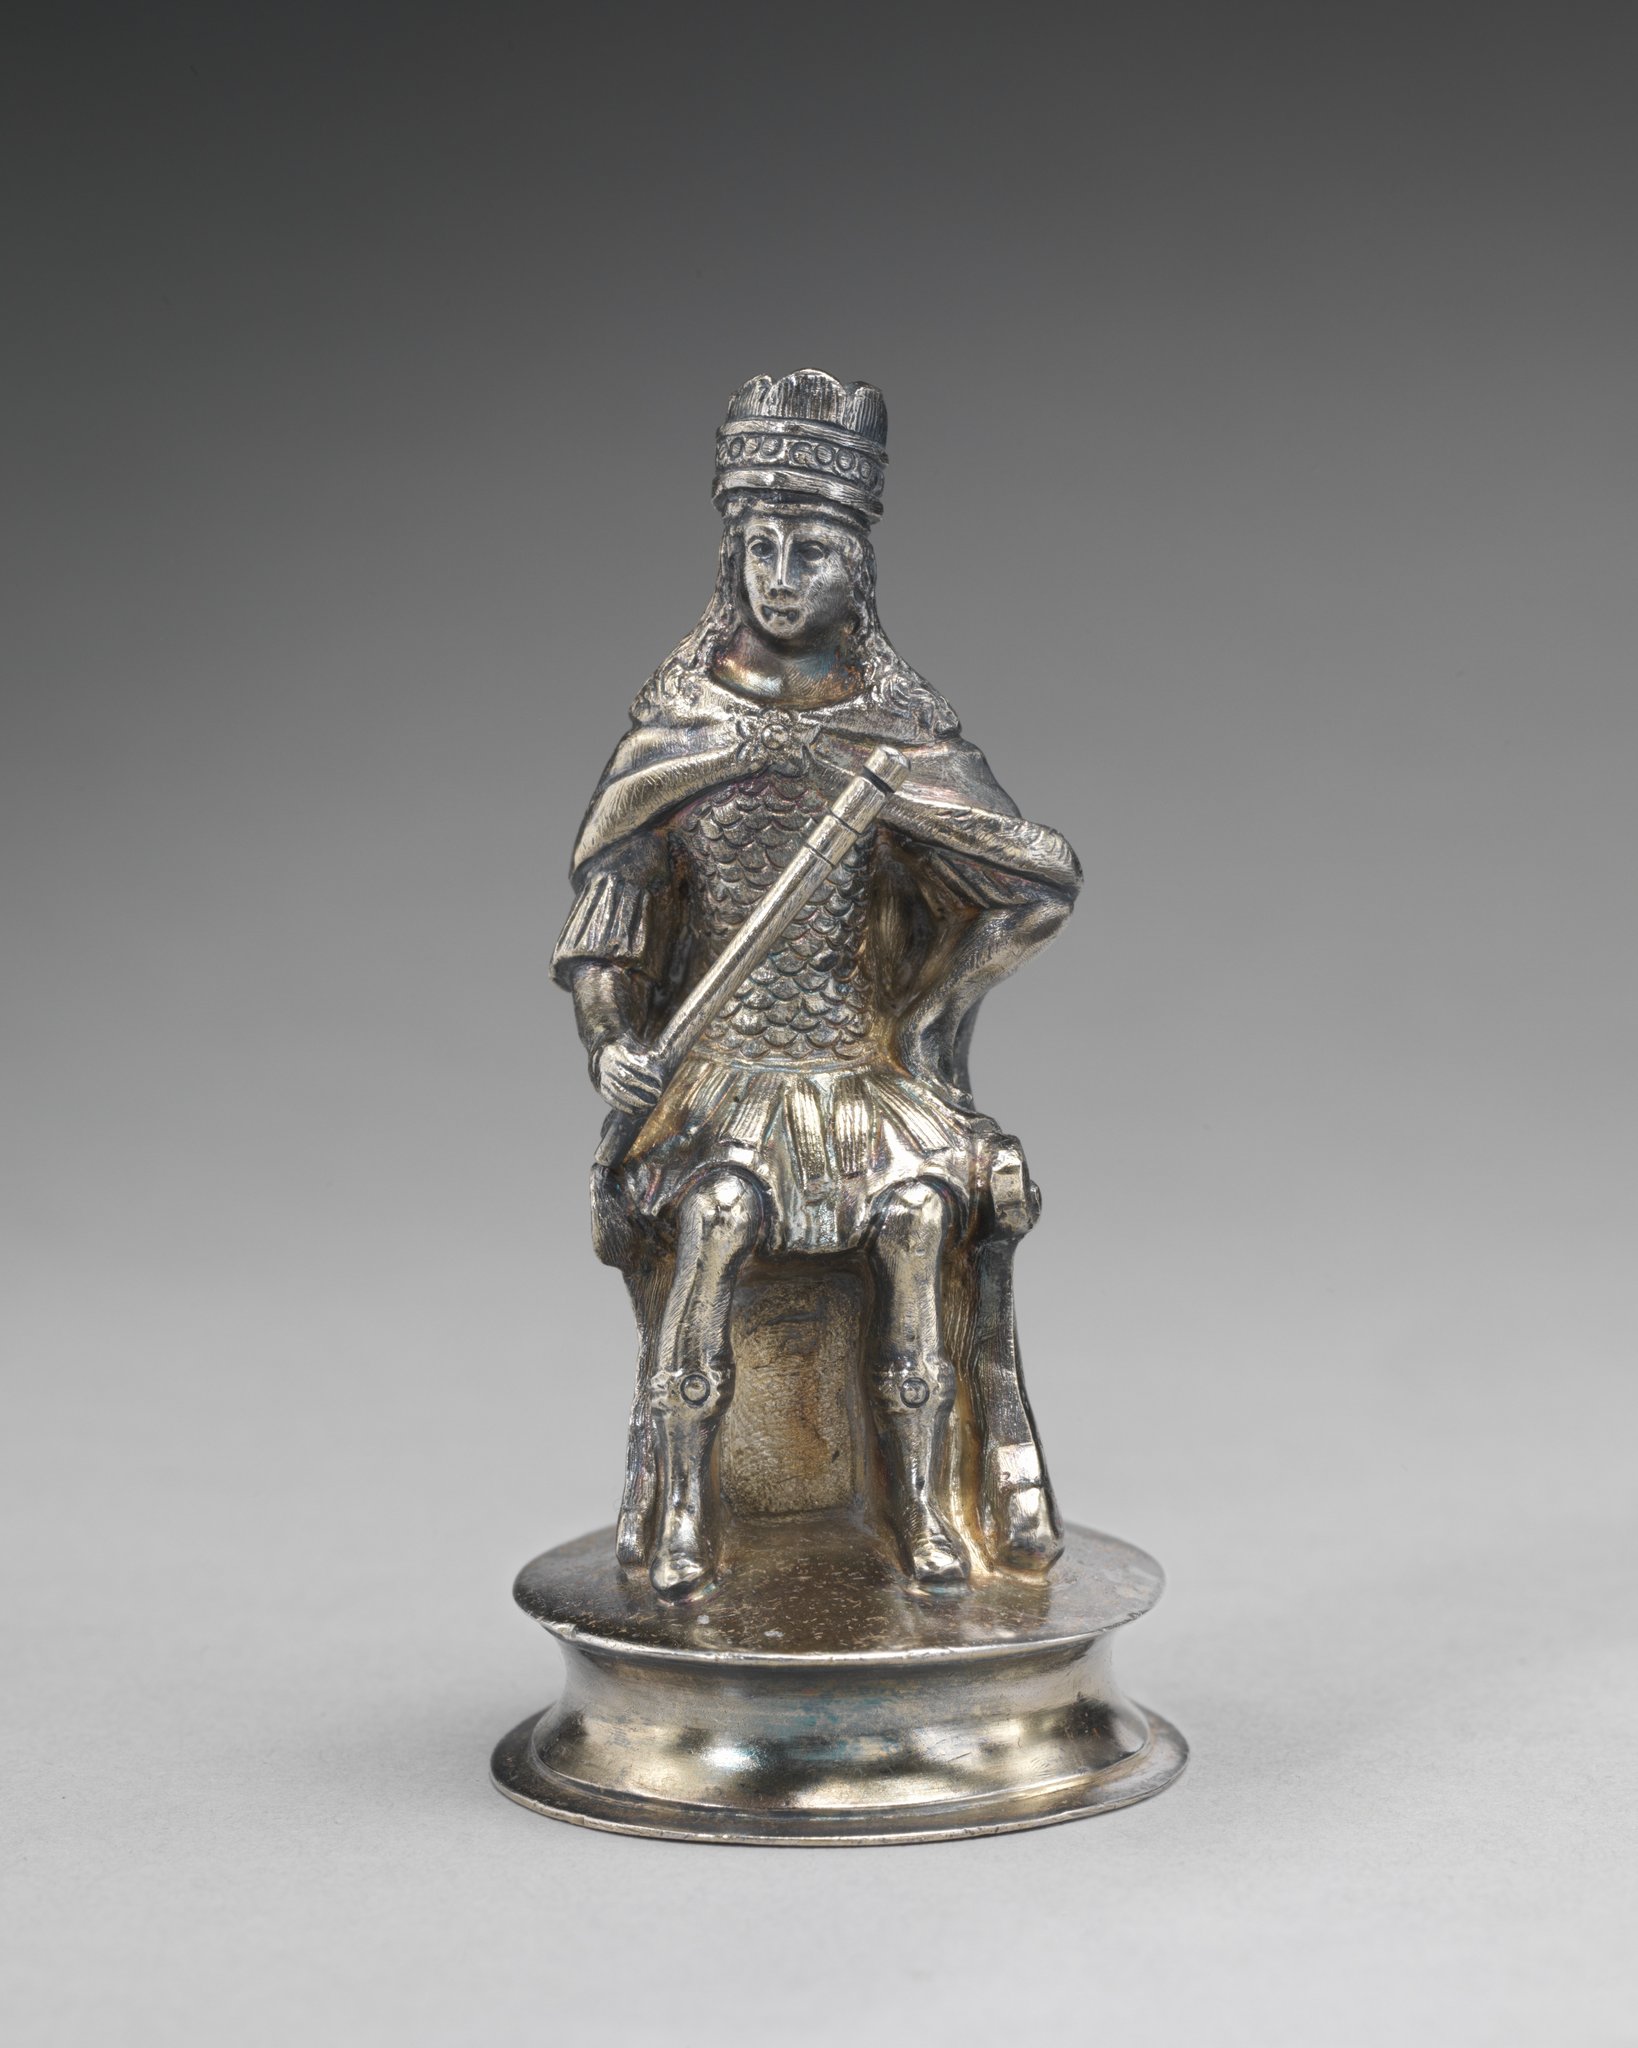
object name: chessman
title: Chessman (King)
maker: elkington & co.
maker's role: manufacturer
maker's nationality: british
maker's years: 1829-1963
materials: metal, silver